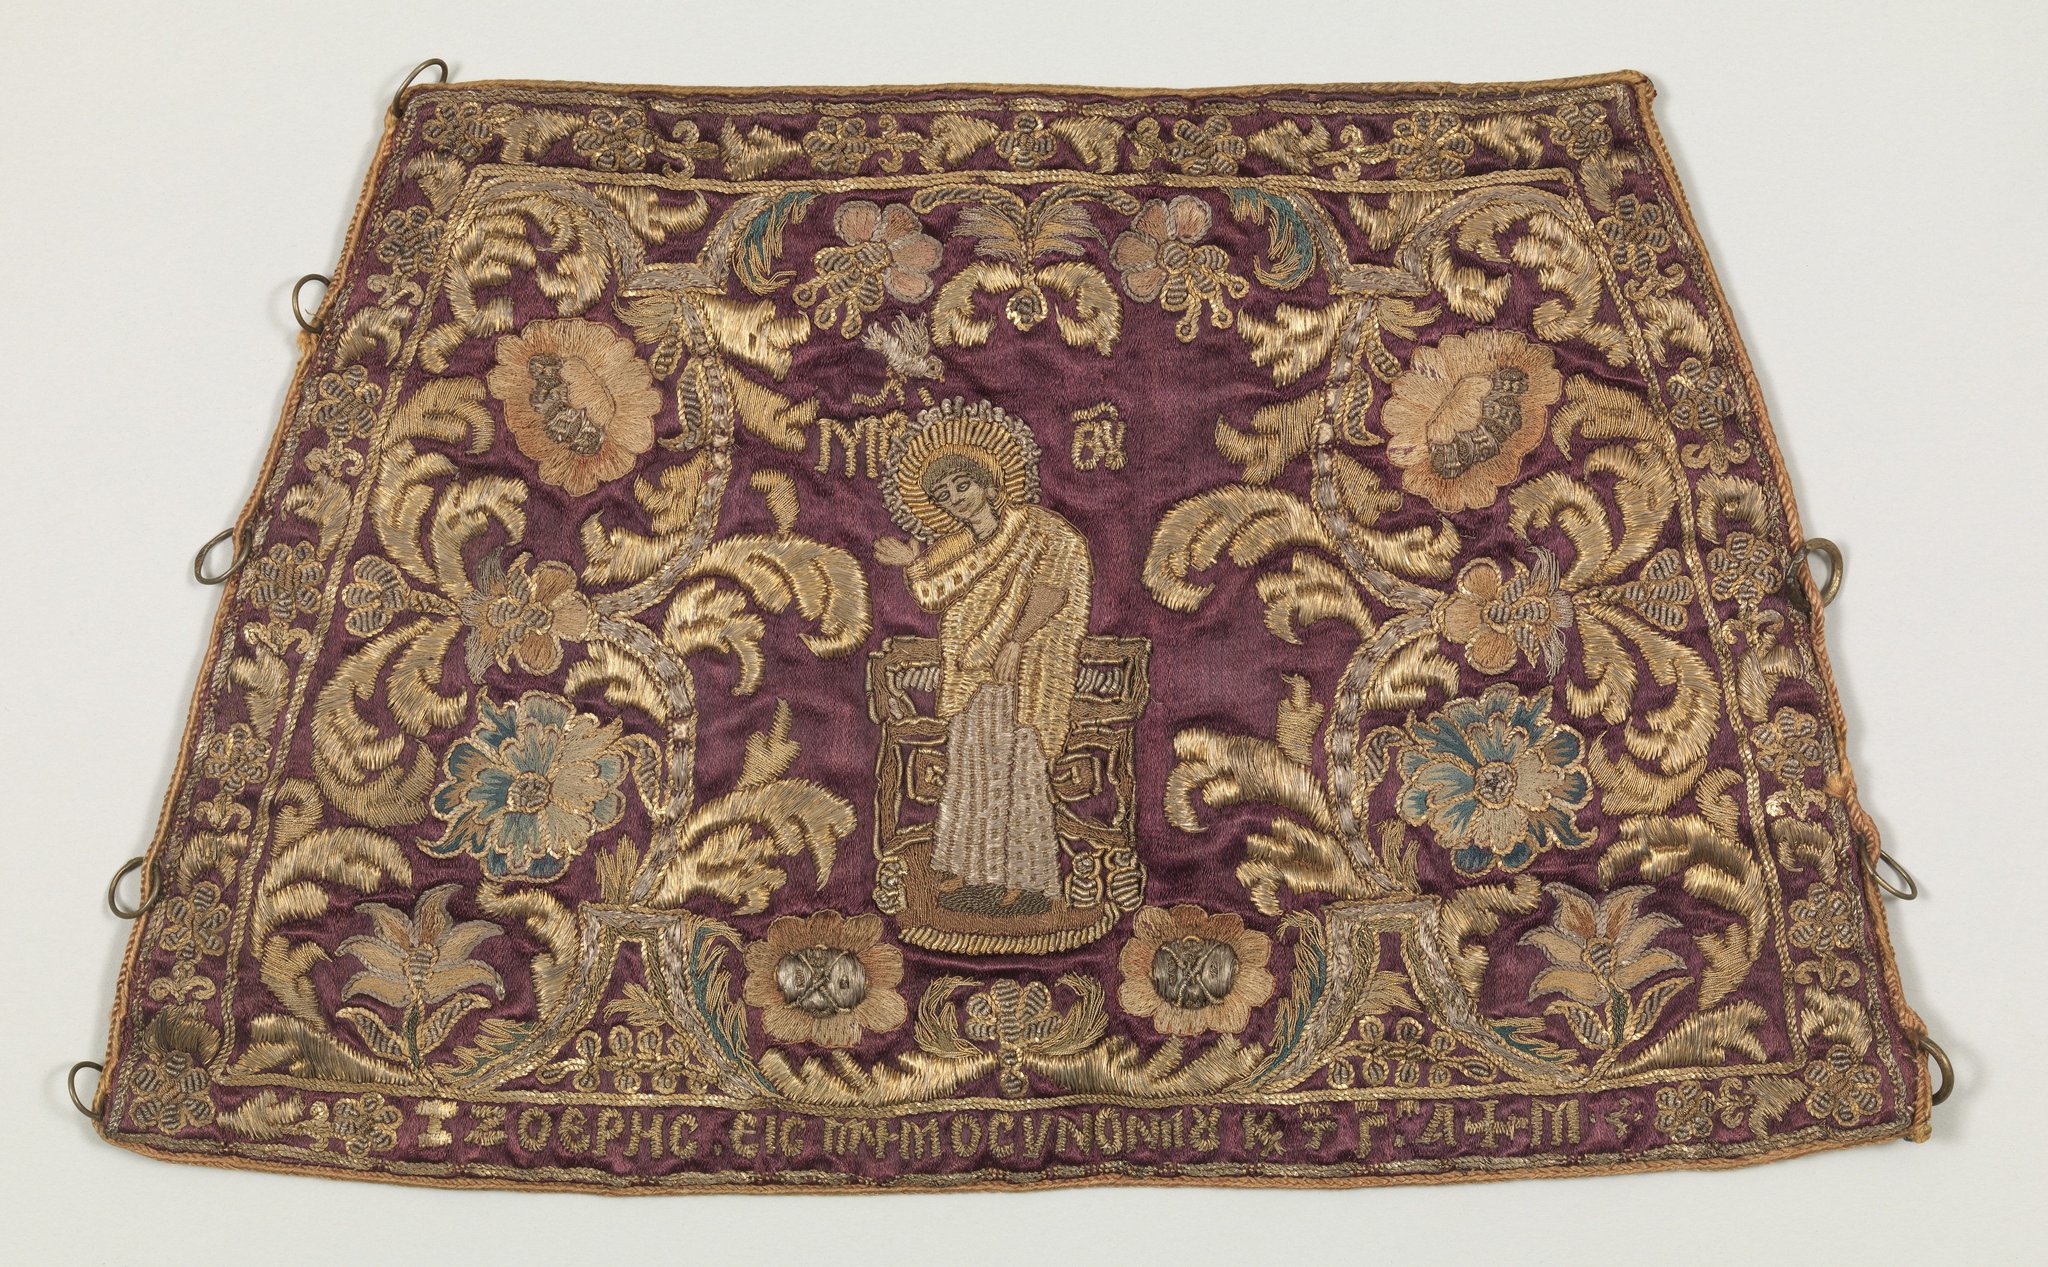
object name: cuff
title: Liturgical cuff (Epimanikion)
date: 1740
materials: metal, metal thread, silk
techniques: embroidery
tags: virgin mary,archangel gabriel,annunciation